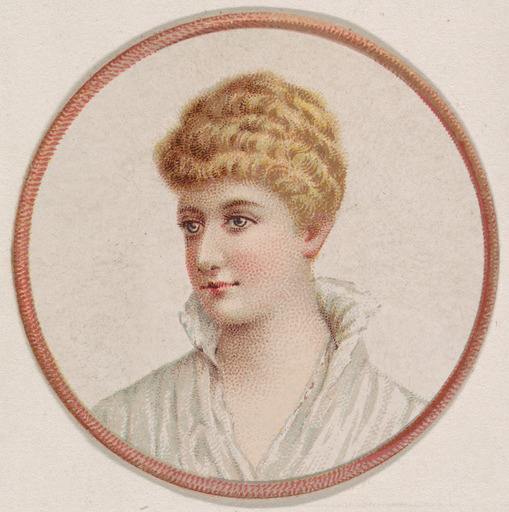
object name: print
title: Portrait of woman, from the Novelties series (N228, Type 2) issued by Kinney Bros.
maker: kinney brothers tobacco company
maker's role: publisher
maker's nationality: american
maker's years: 1869-2011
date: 1889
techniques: color lithograph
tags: portraits,women